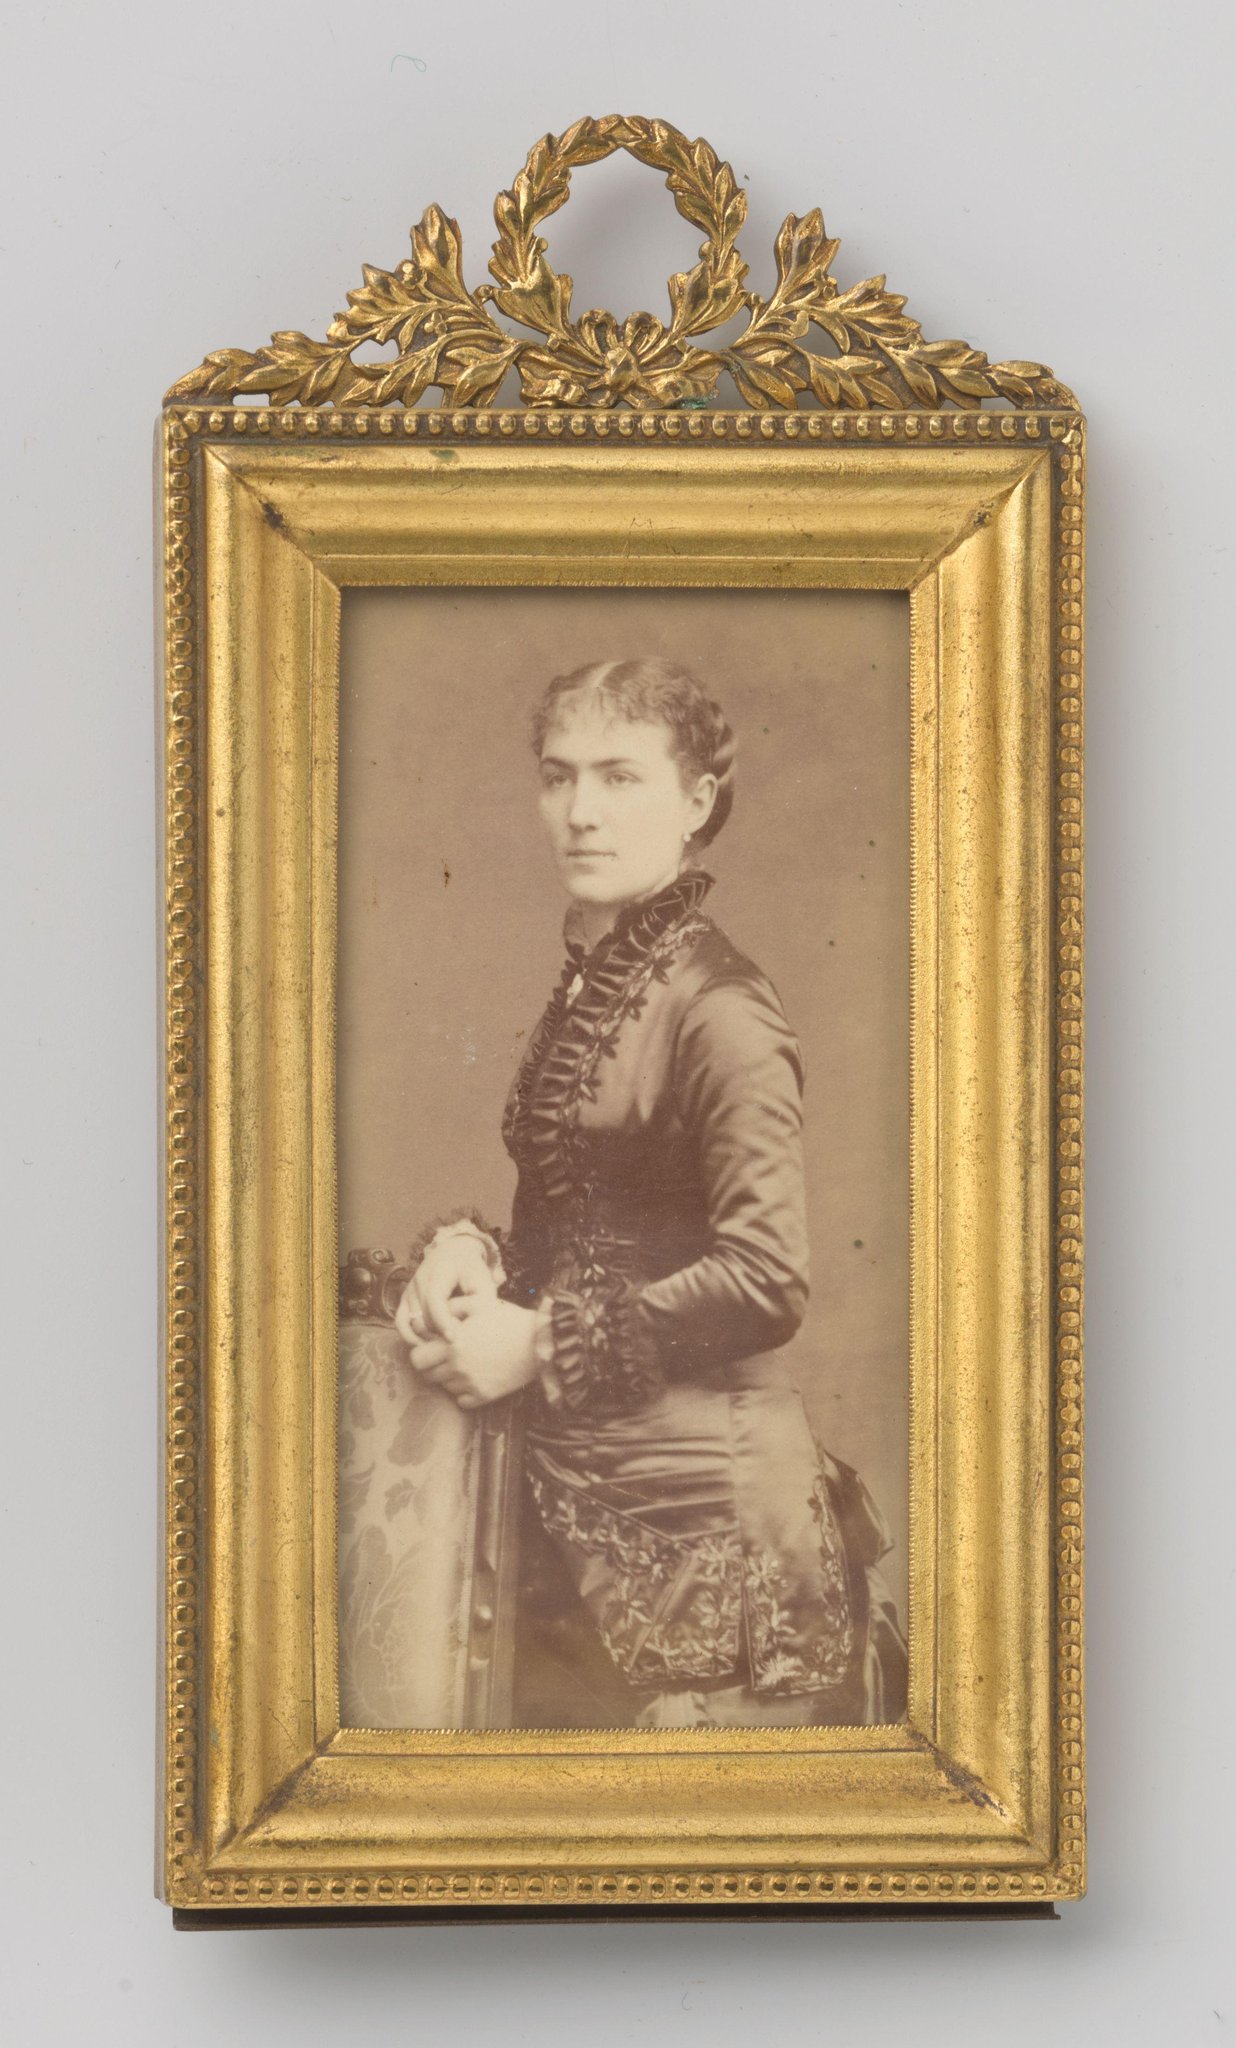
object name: frame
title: Portret van een onbekende jonge vrouw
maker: Anonymous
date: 1880-1900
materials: glass, metal, paper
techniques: albumen print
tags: adolescent, young woman, maiden, anonymous historical person portrayed